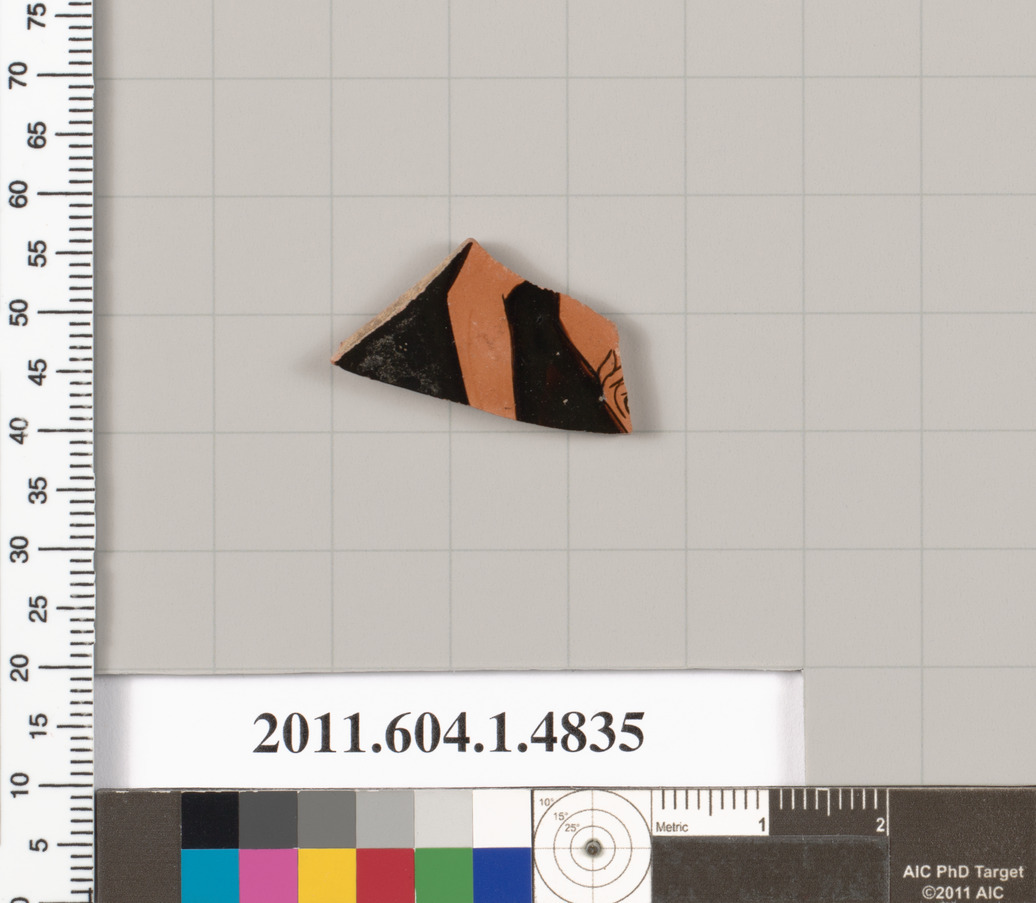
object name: kylix fragment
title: Terracotta fragment of a kylix (drinking cup)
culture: greek, attic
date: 500-480 BCE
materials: terracotta